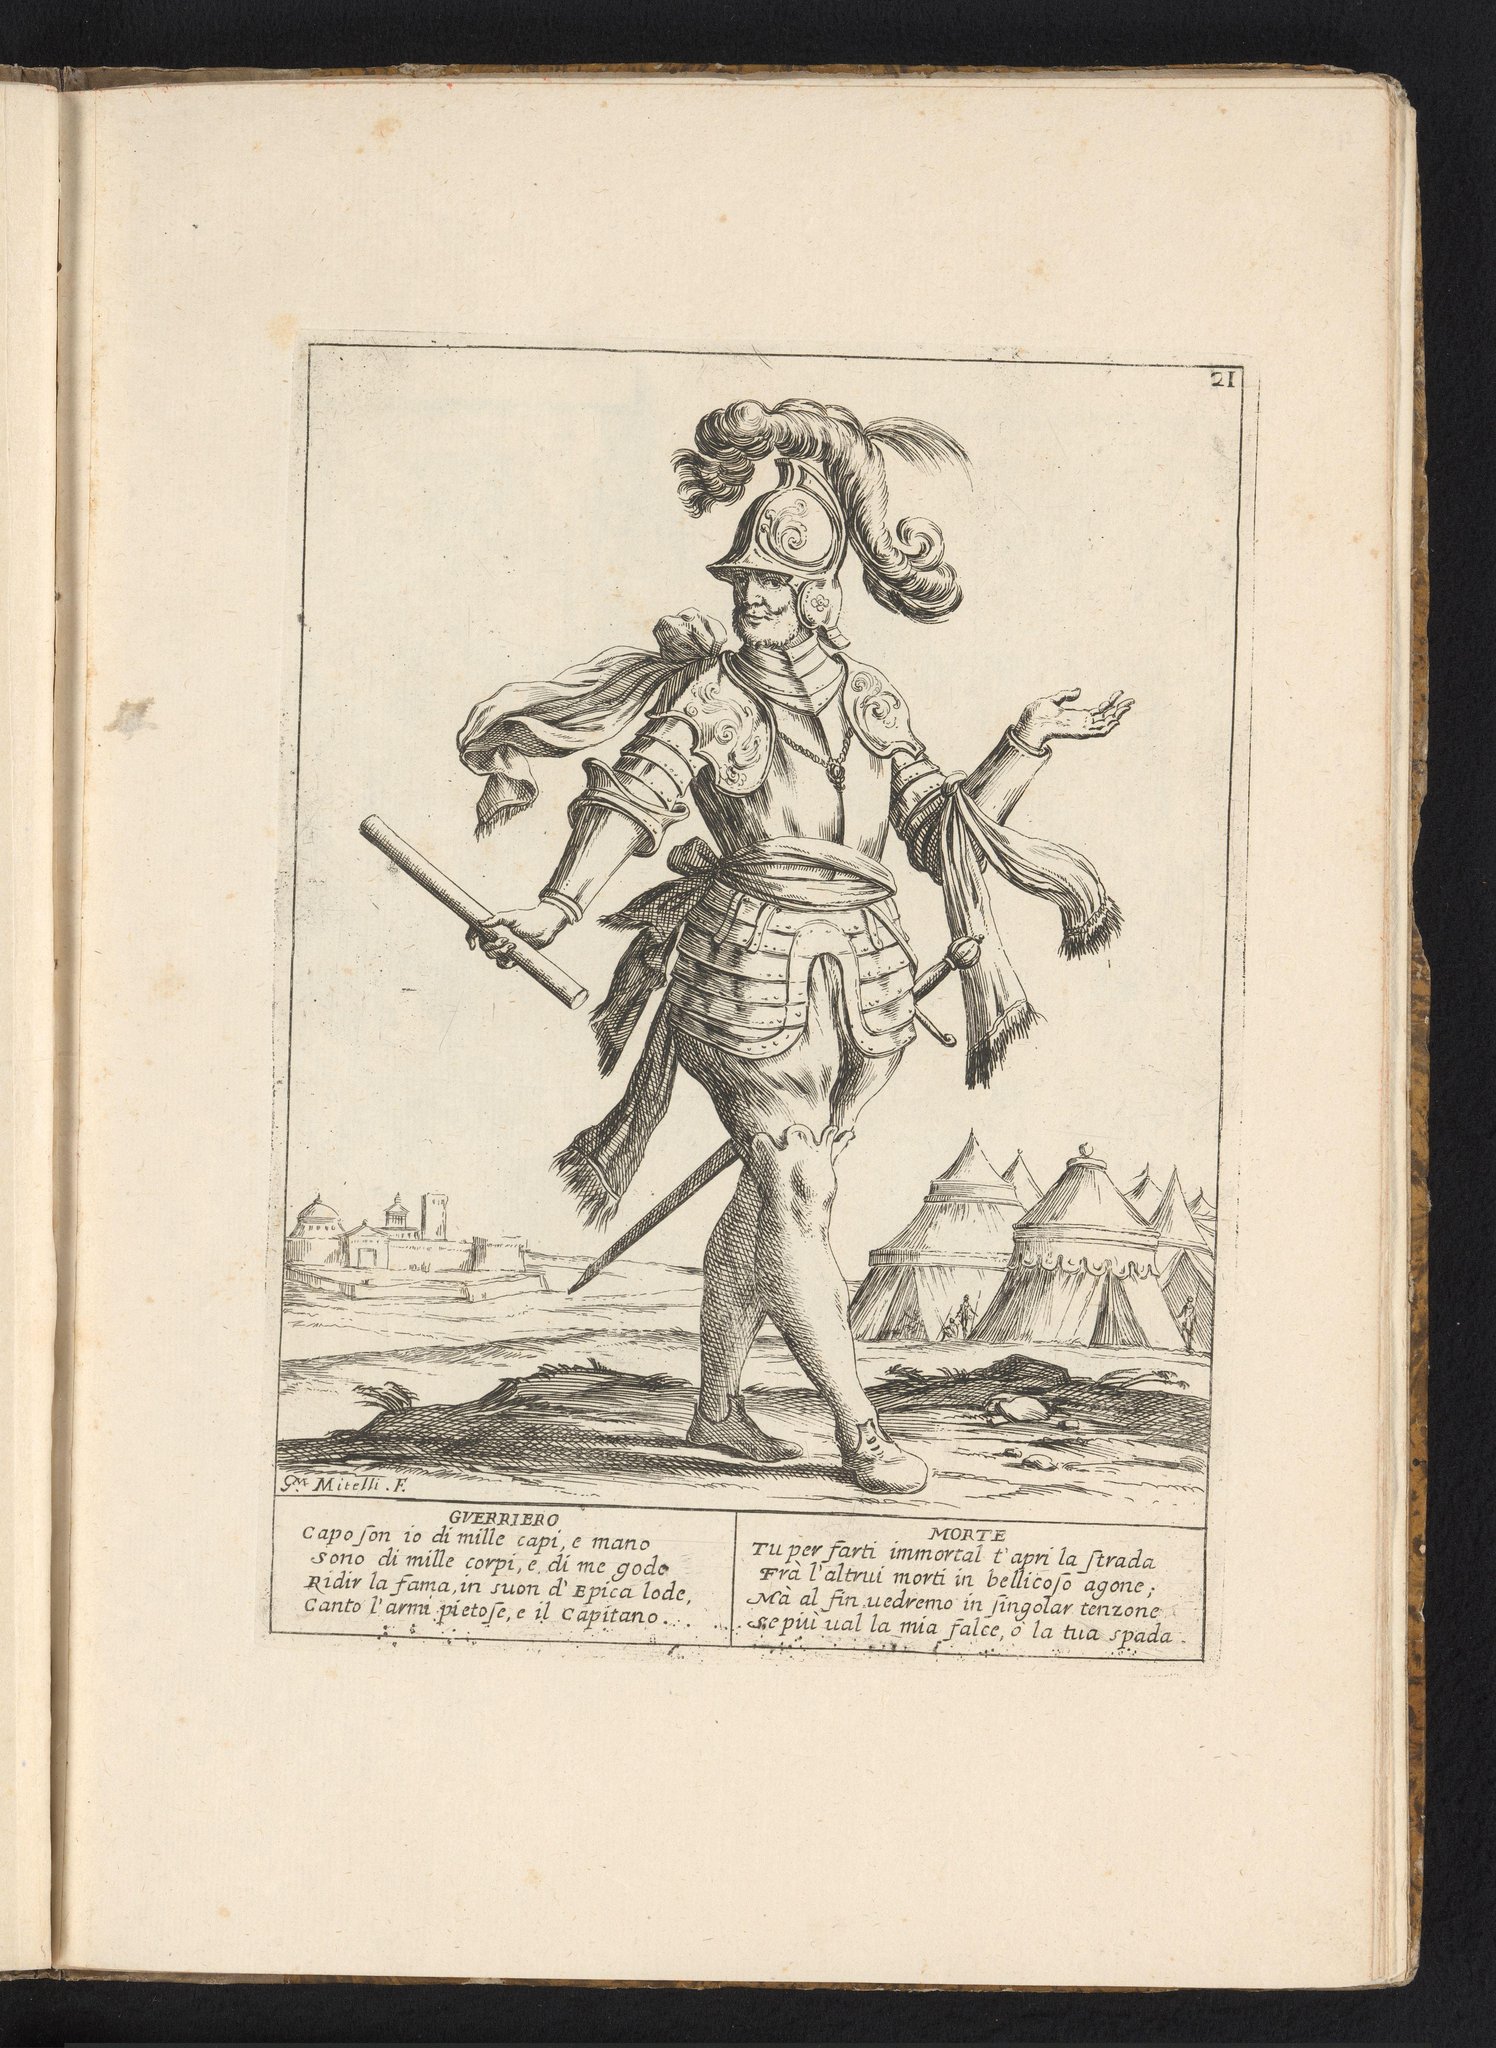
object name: print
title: De soldaat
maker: giuseppe maria mitelli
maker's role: draughtsman, painter, print maker, publisher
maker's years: 1634-1718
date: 1675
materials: paper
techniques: engraving, etching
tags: (military) camp with tents, scenes symbolizing 'vanitas', commander-in-chief, general, marshal, the 24 hours of day and night, personifications ~ the life of man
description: Een soldaat (Guerriero). Staande militaire bevelhebber, commandostaf in de hand, rechts een legerkamp. Met twee vierregelige verzen in het Italiaans. Genummerd rechtsboven: 21. Onderdeel van de serie 'De vierentwintig uren van het menselijk geluk'.